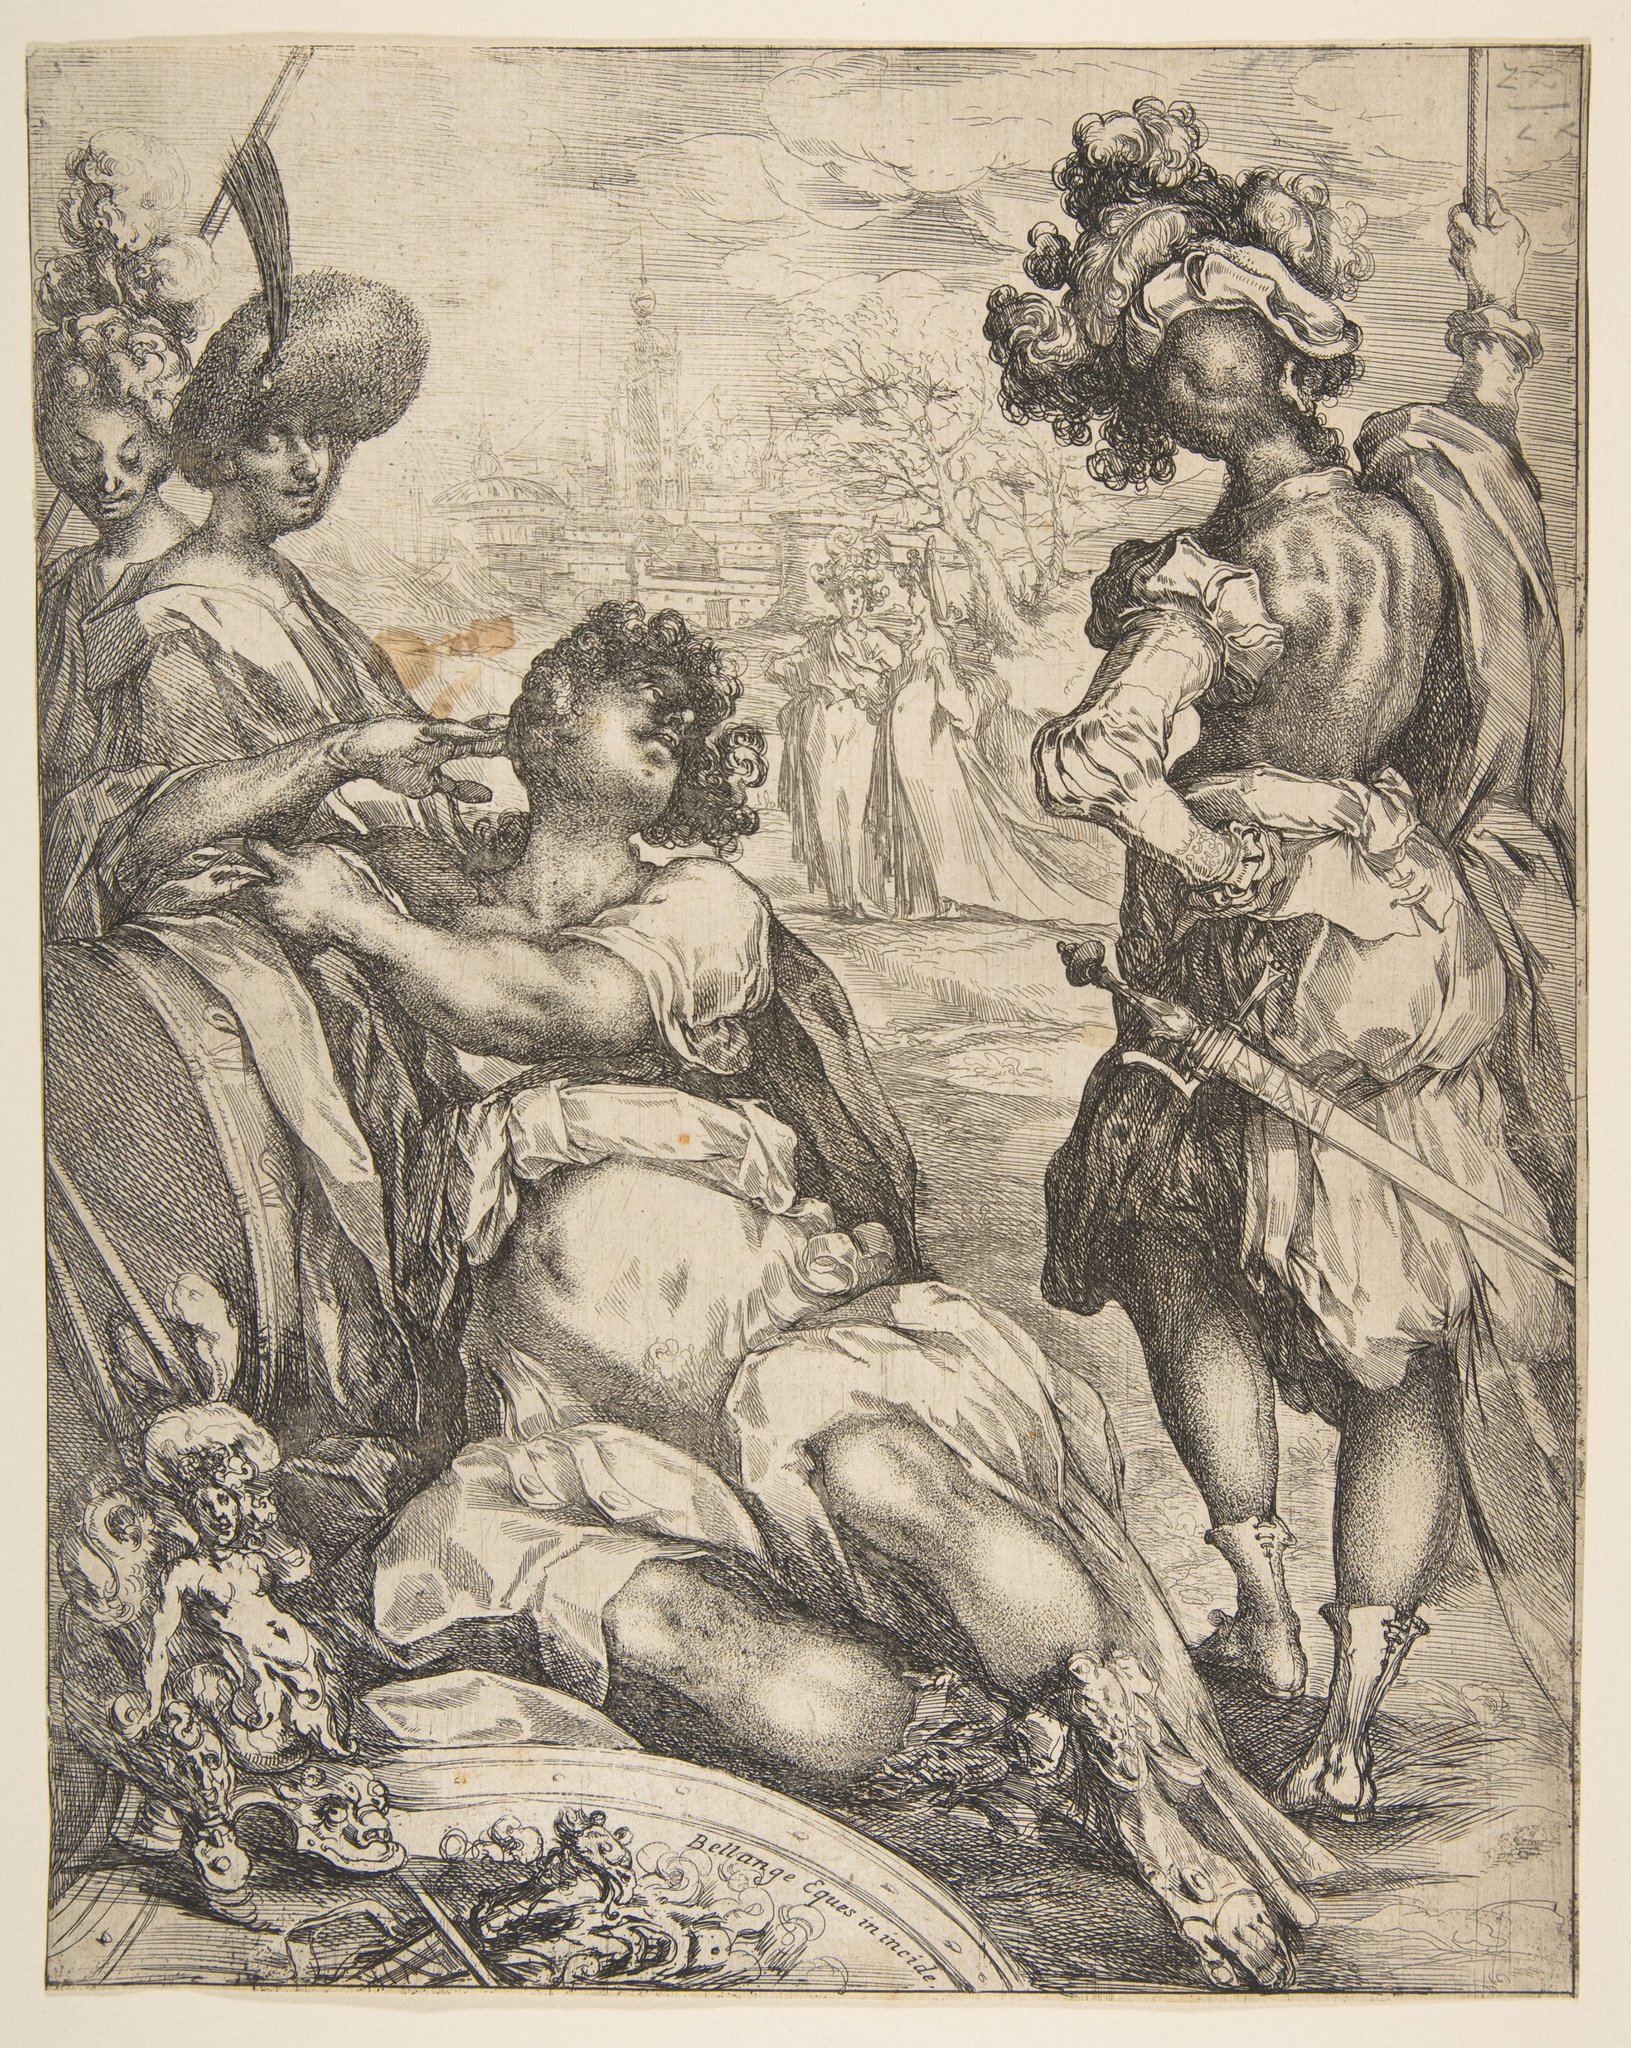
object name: print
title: Military Figures outside a City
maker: jacques bellange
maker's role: artist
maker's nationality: french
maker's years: 1575-1616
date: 1595-1616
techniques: etching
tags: military